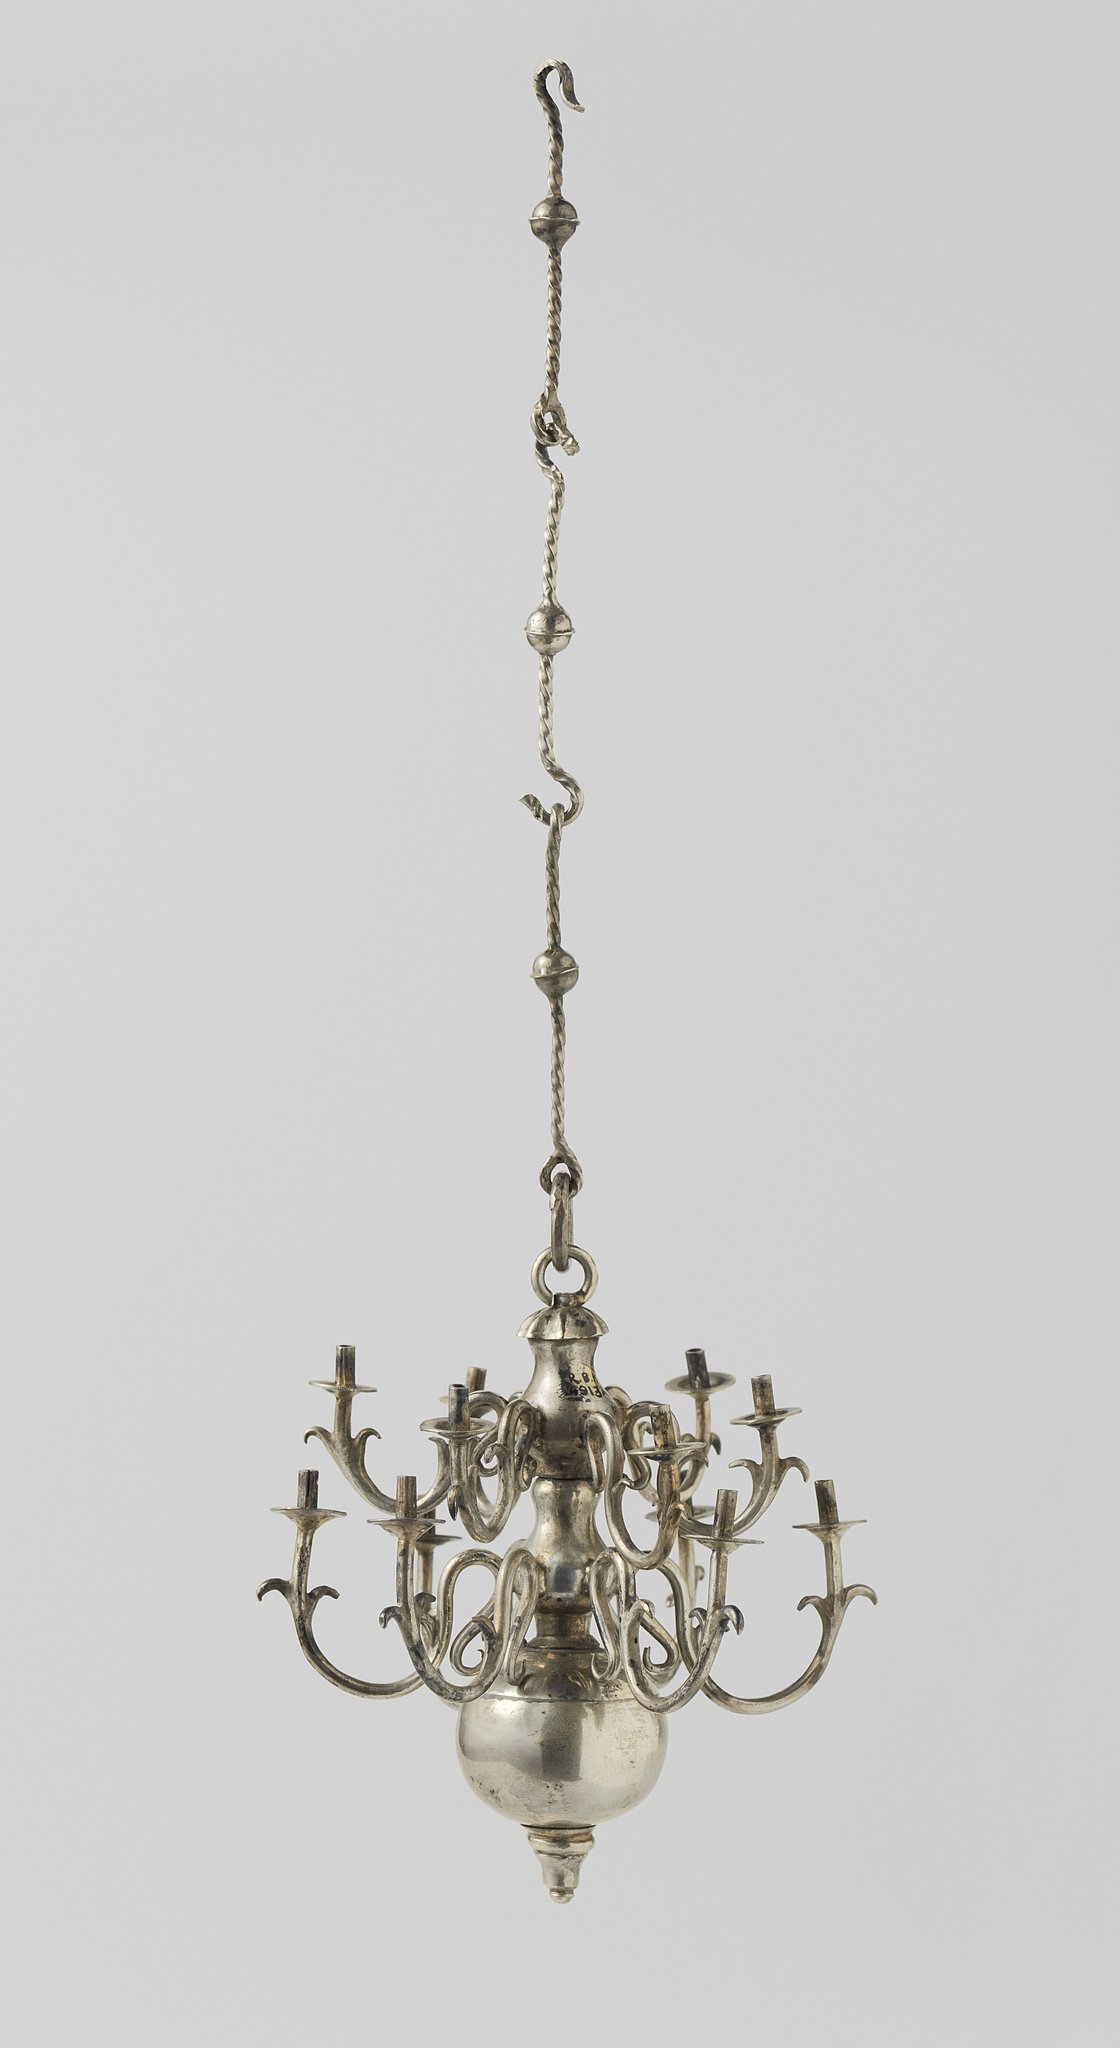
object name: miniature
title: Kaarsenkroon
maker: c. van der aa (zilversmid)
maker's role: silversmith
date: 1863-1881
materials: silver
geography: schoonhoven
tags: chandelier, candelabrum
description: Kroon met twee rijen van zes armen boven elkaar, bevestigd aan een geprofileerde stam met aan de onderkant een bol. Aan de bovenkant van de stam zit een ring, waaraan drie aan elkaar gehaakte stangen zijn bevestigd. De stangen zijn gedraaid en hebben ieder in het midden een bol. De kroon is gemerkt: mt.= C. van der Aa en een zwaard.